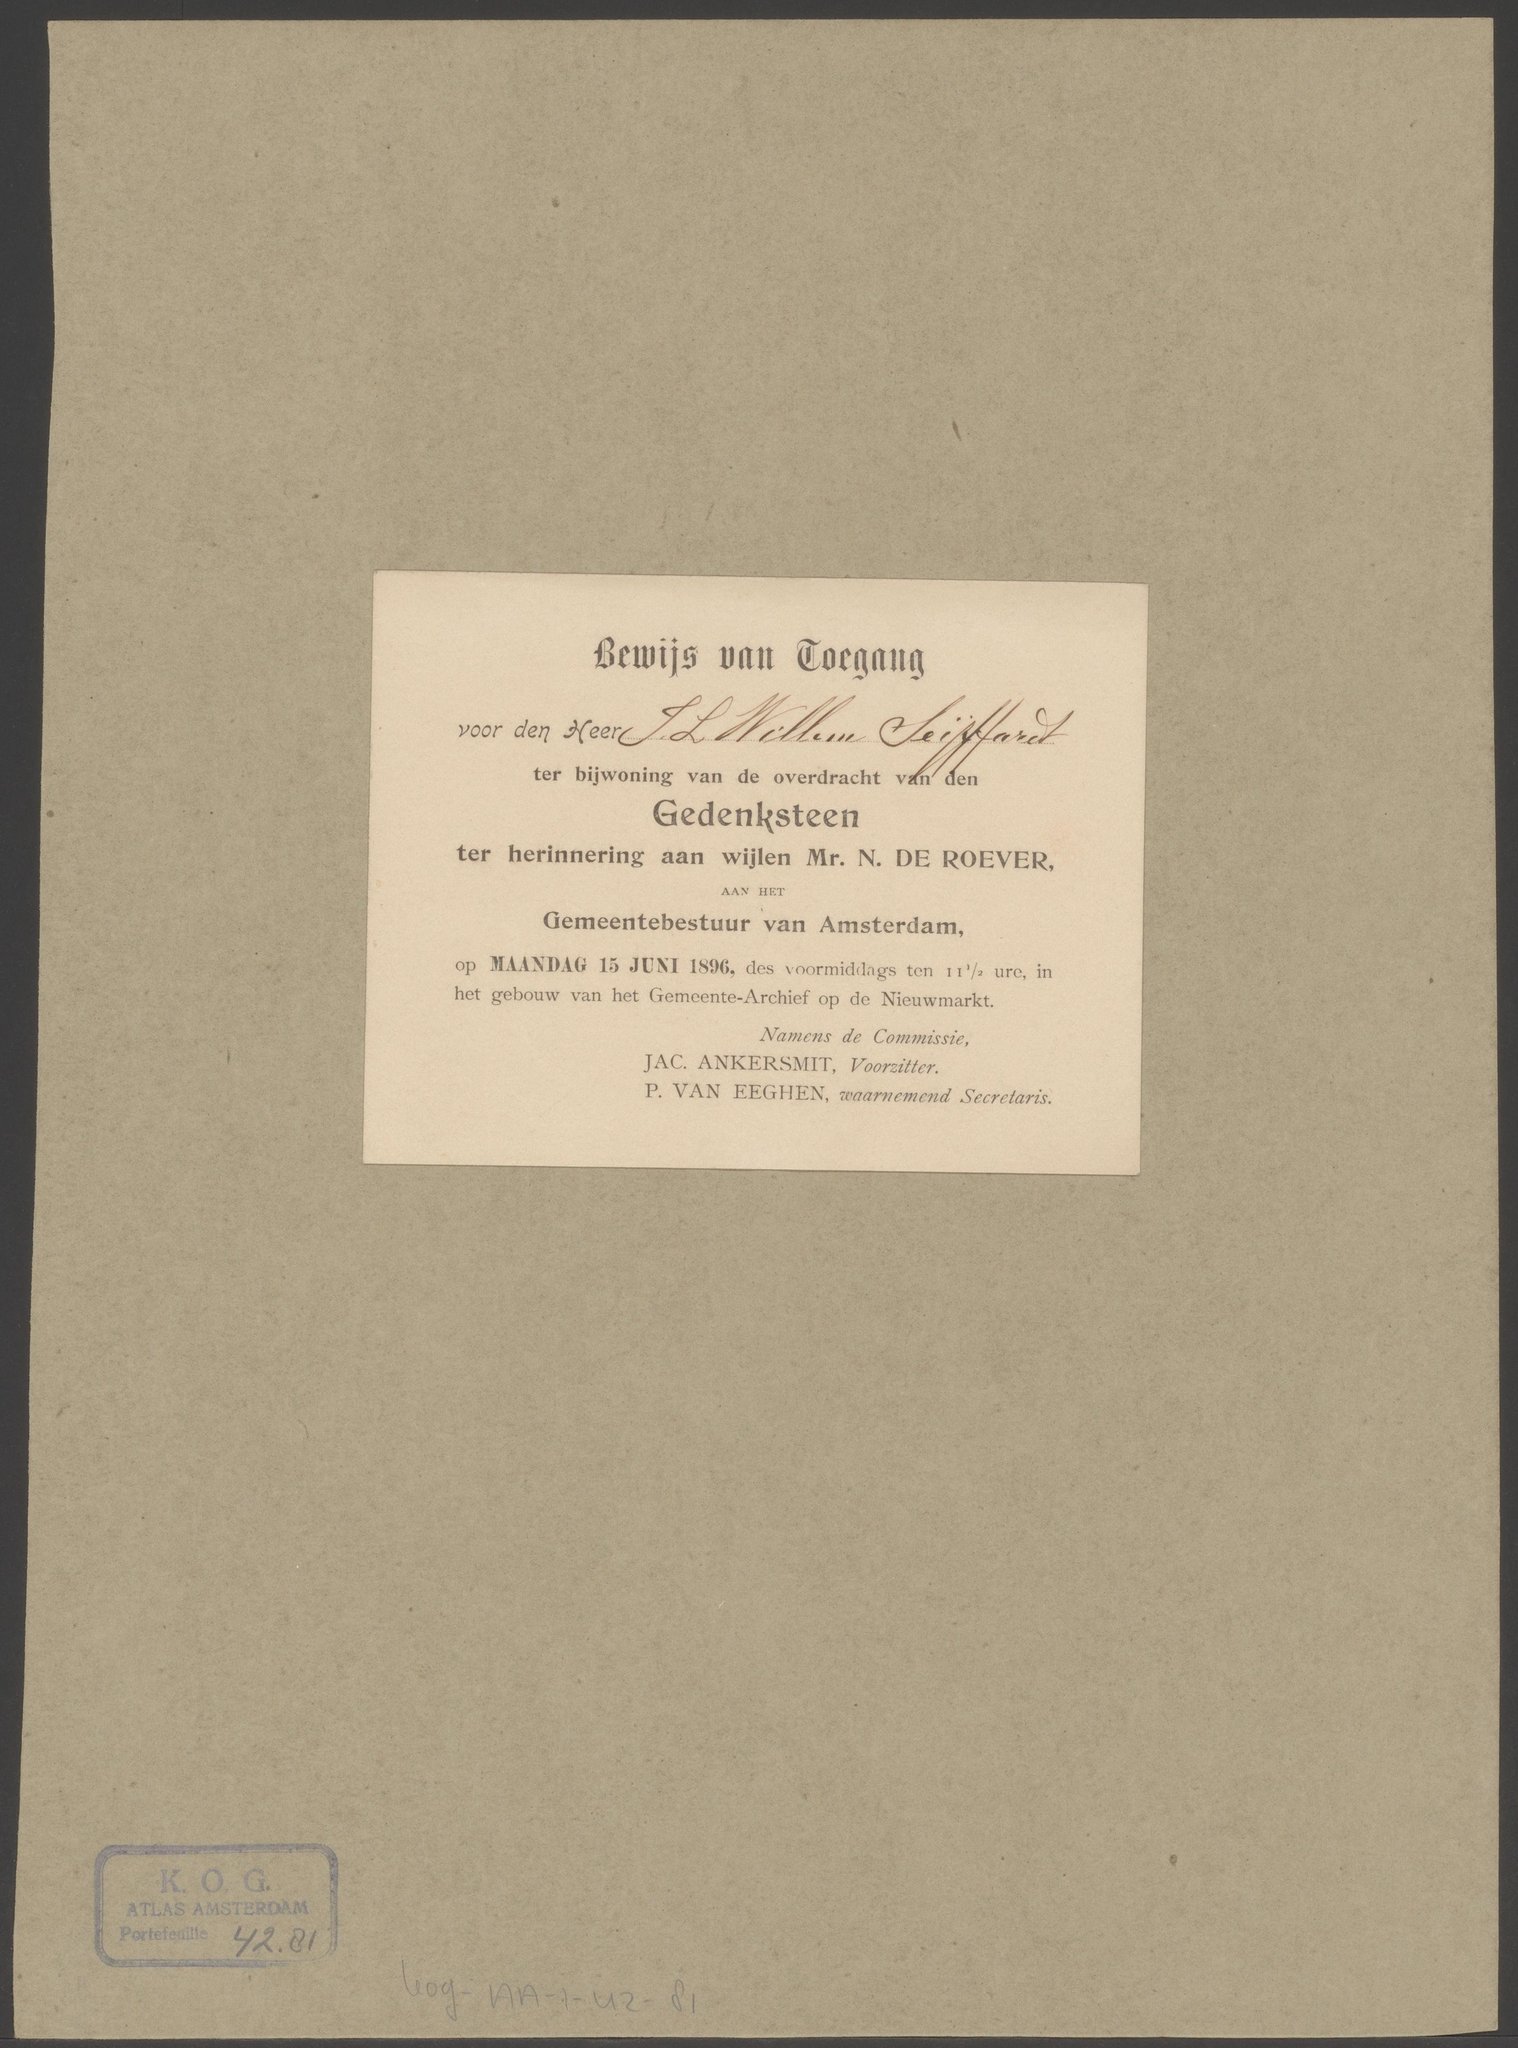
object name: admission ticket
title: Toegangsbewijs voor de overdracht van de gedenksteen van Nicolaas de Roever aan de Gemeente Amsterdam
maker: Anonymous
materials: paper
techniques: handwriting, letterpress printing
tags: milk, selling, weigh-house, amsterdam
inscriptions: collector's mark: Lugt 1461b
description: Onderwerpsrubriek binnen de Atlas Amsterdam: Markten, handel: C. Veemen, Waaggebouwen.